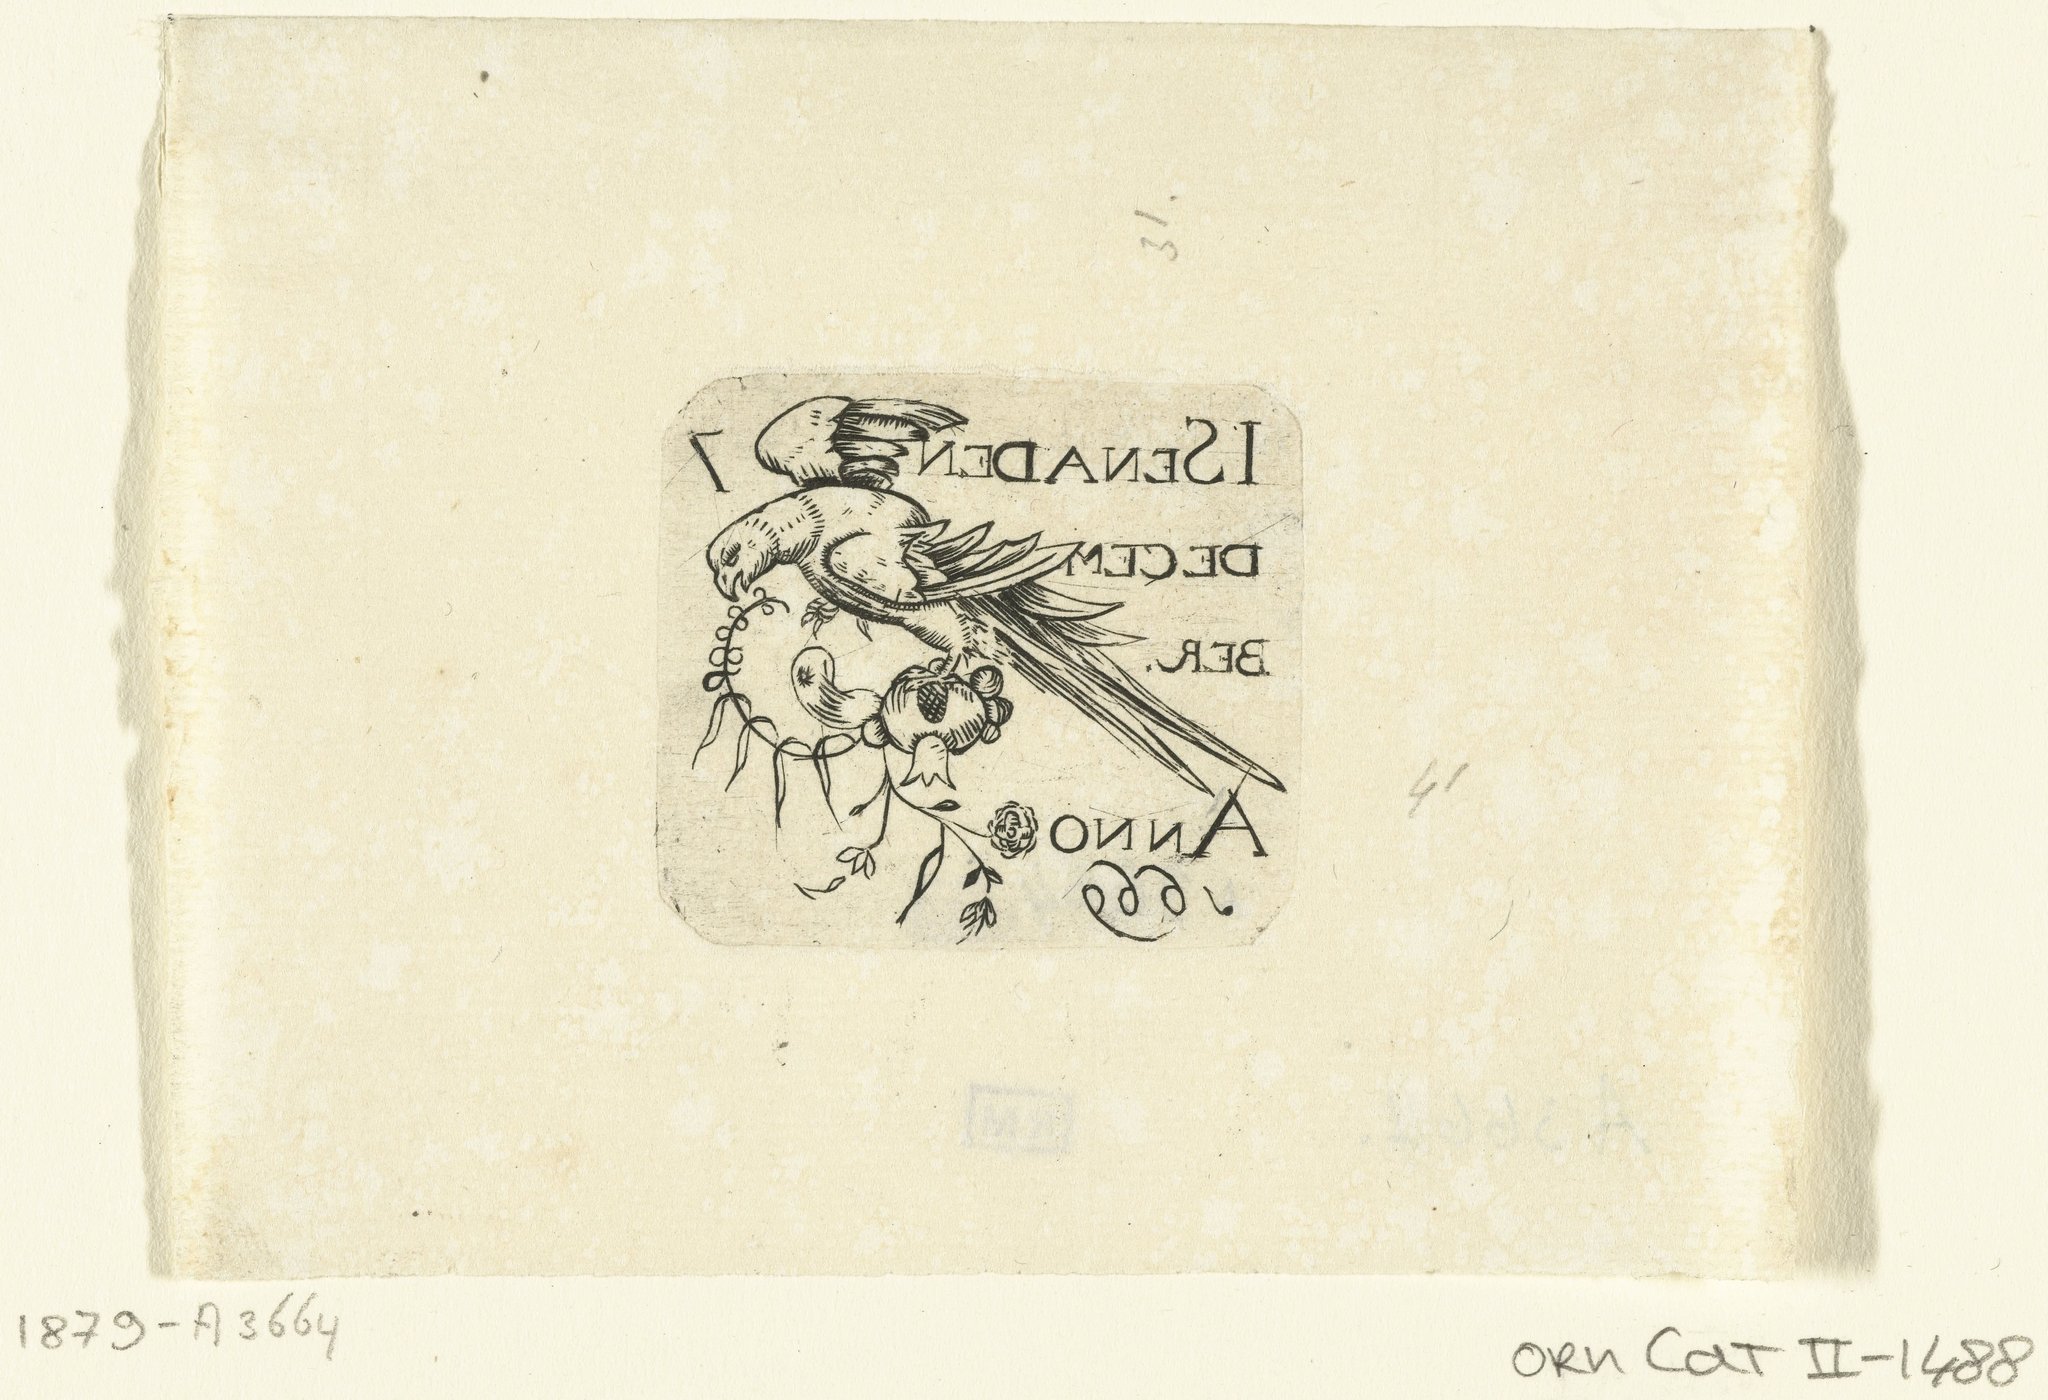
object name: ornament print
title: Papegaai op een vrucht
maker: Anonymous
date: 1669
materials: paper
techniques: etching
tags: ornamental birds: parrot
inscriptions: date